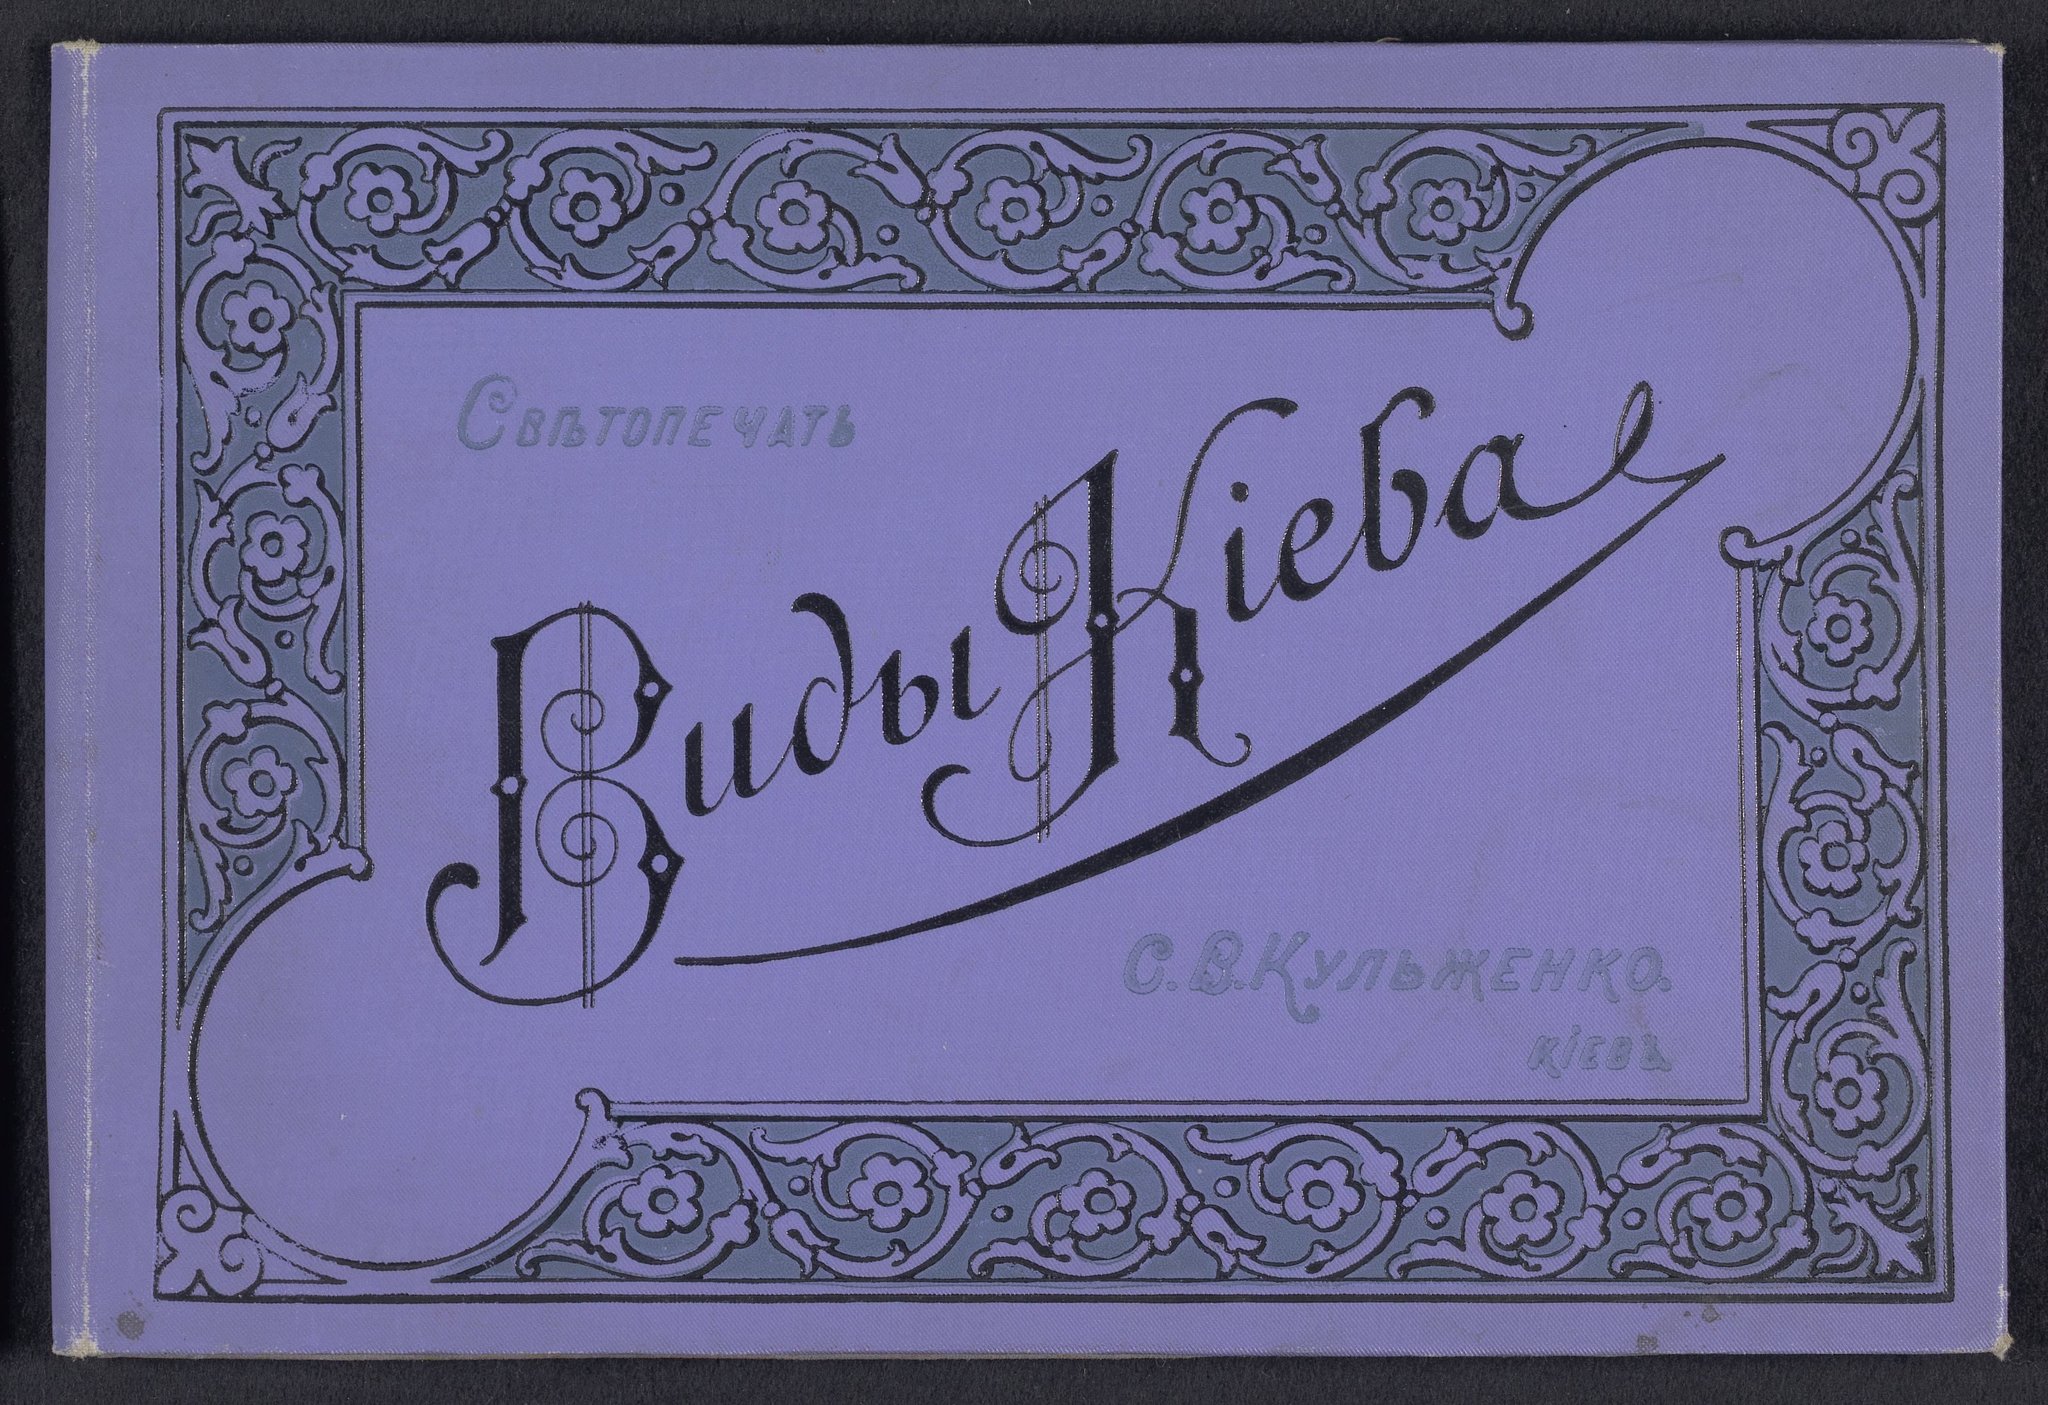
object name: page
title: Viby Kieva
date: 1896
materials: cardboard, linen, paper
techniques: photograph, printing